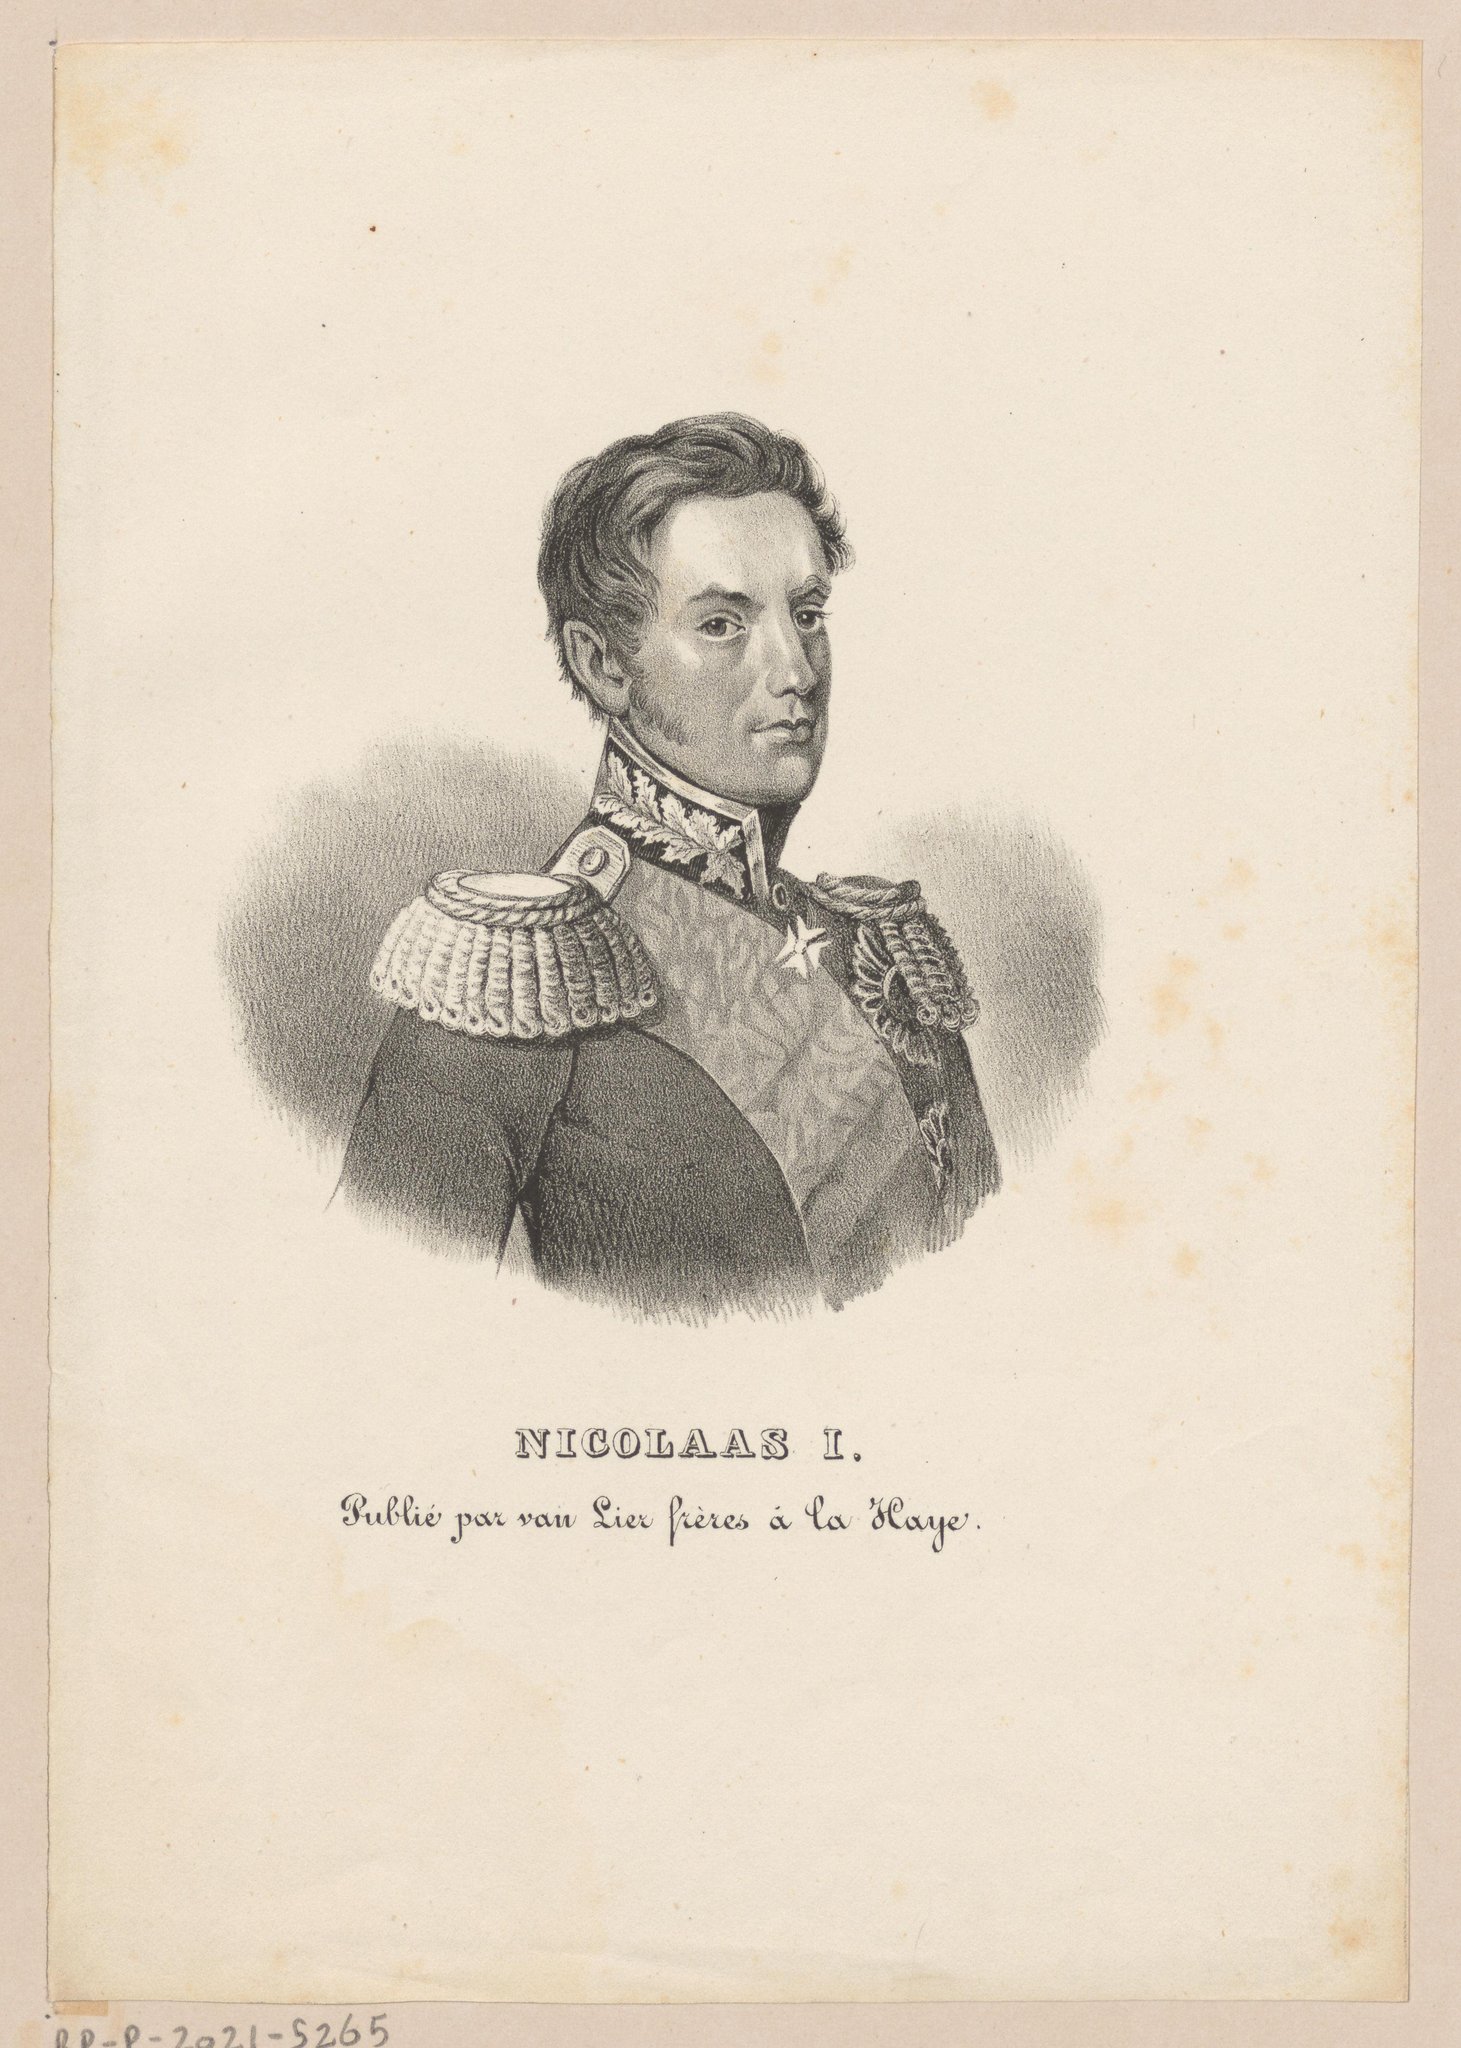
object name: print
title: Portret van Nicolaas I Pavlovitsj, tsaar van Rusland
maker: Anonymous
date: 1833-1846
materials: paper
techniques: lithograph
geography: the hague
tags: historical persons, emperor